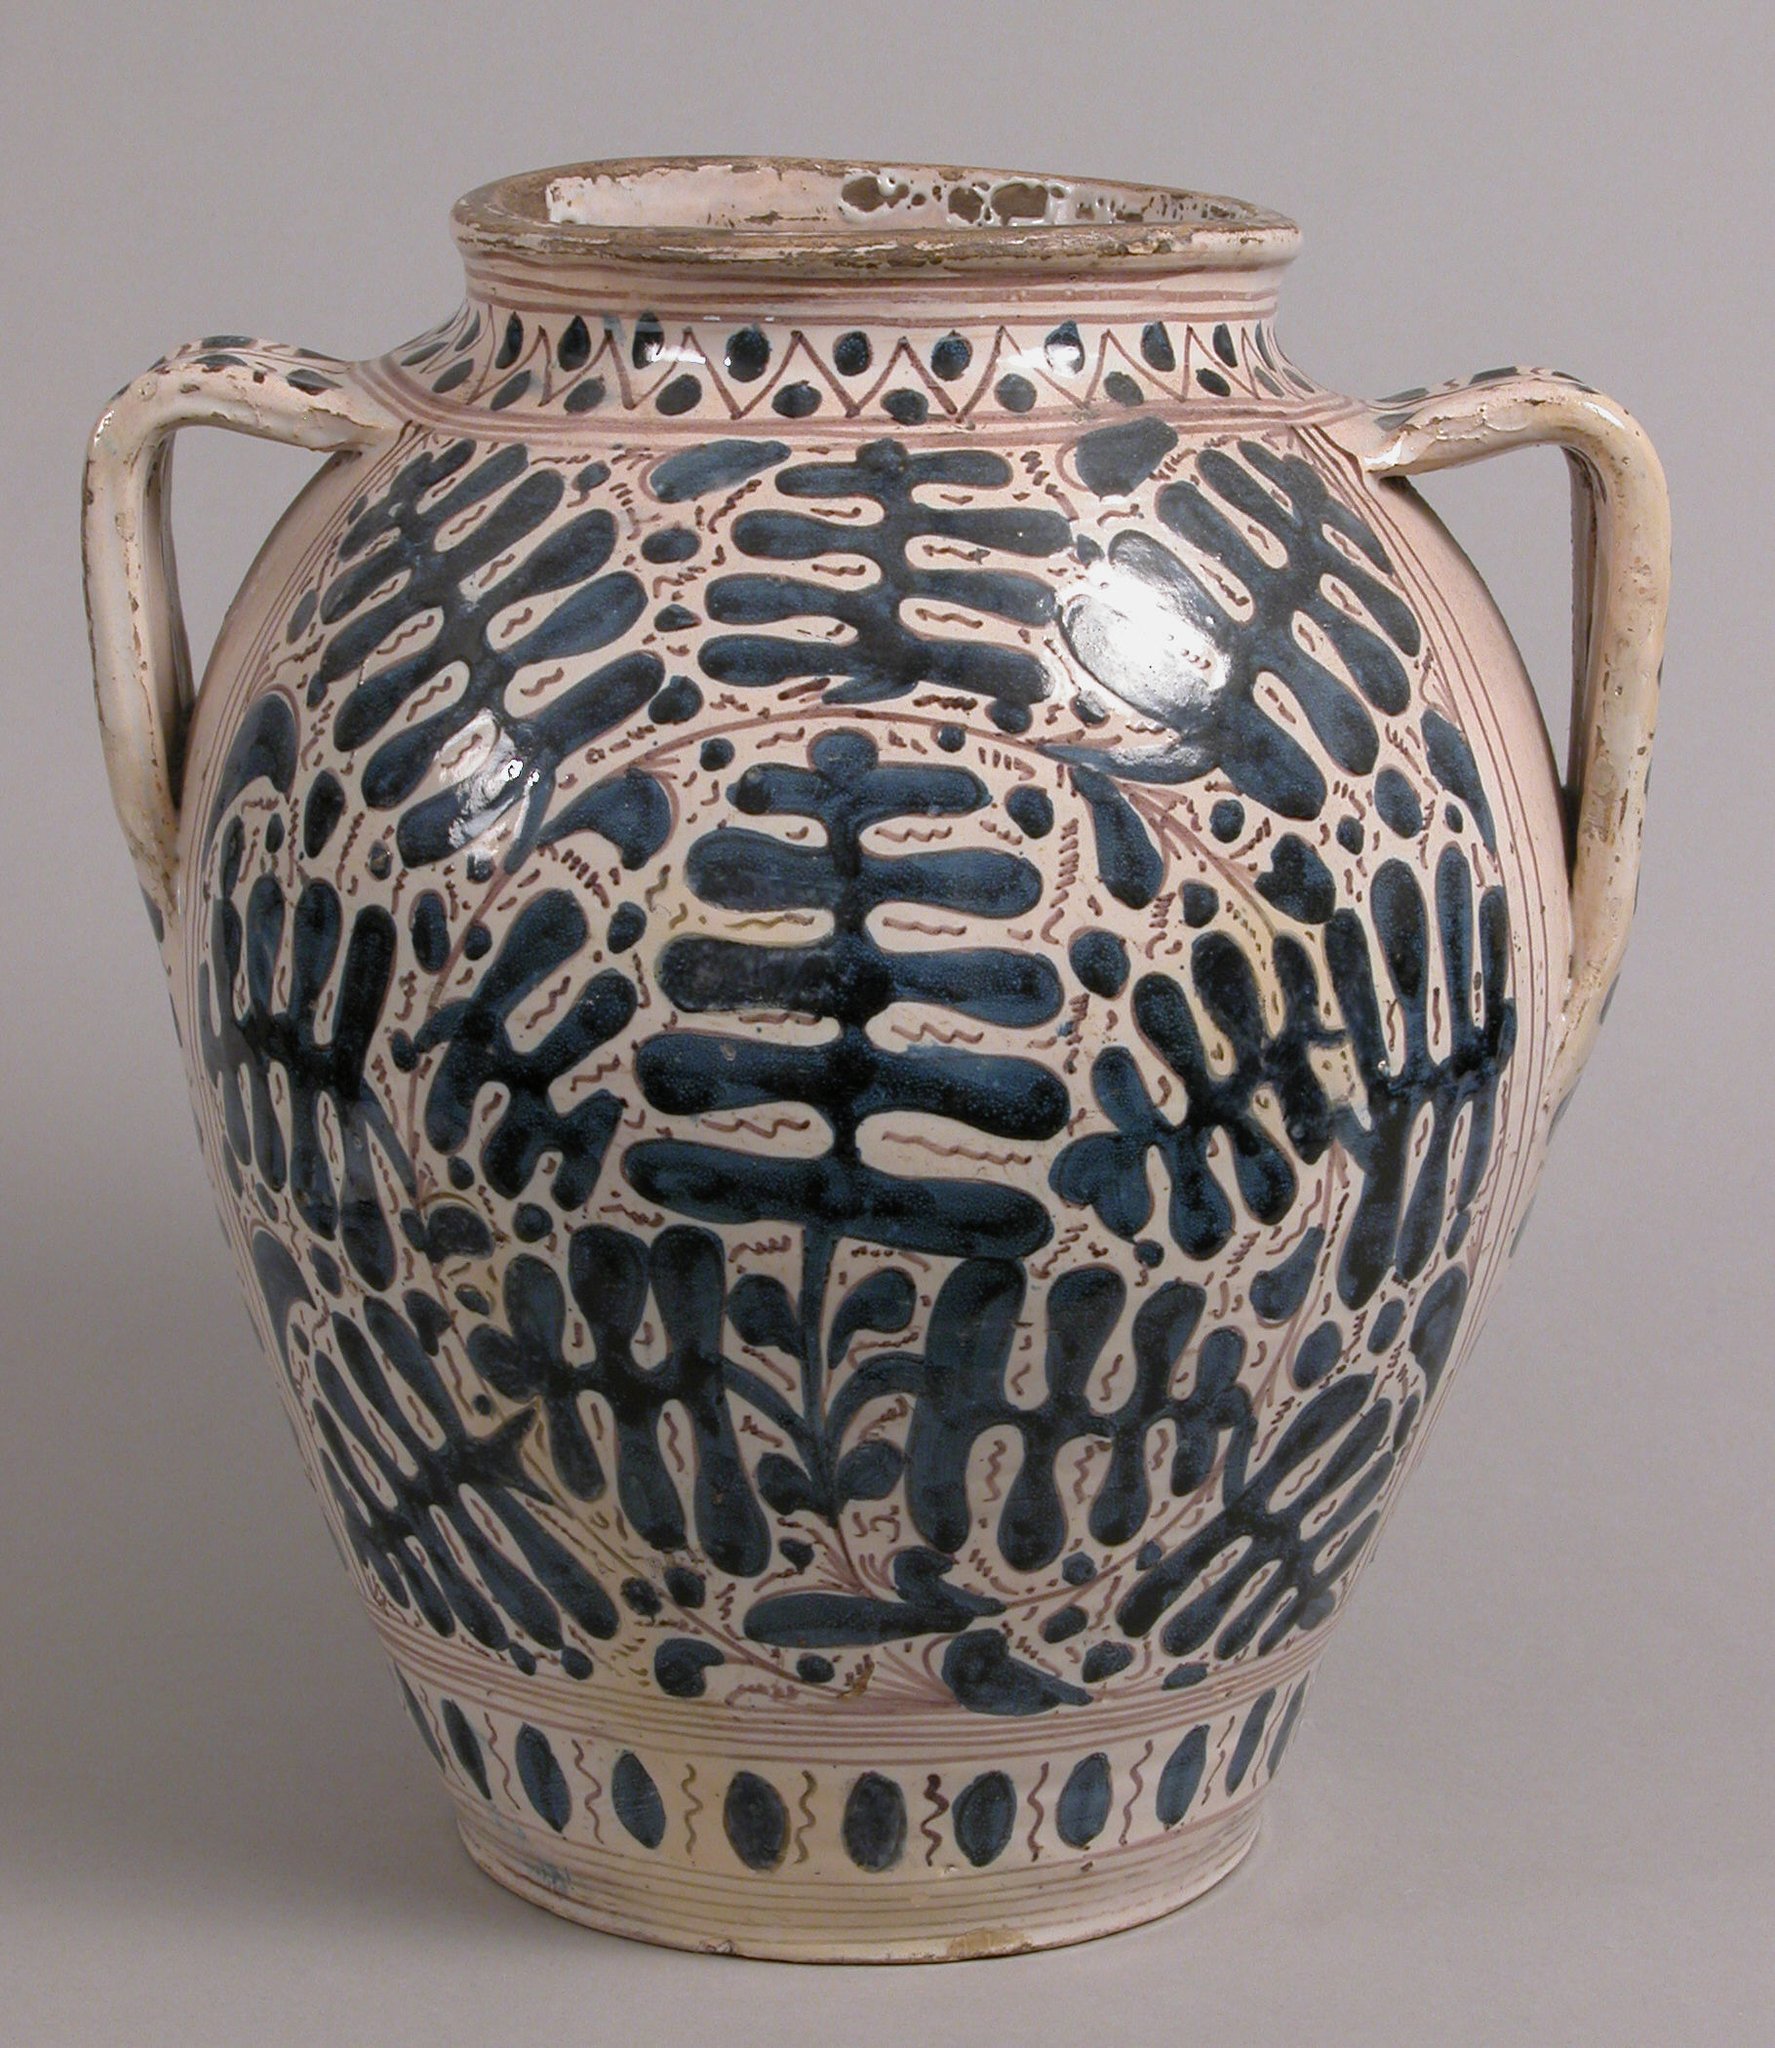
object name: jar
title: Two-Handled Jar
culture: italian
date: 1401-1433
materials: earthenware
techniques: glazing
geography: italy